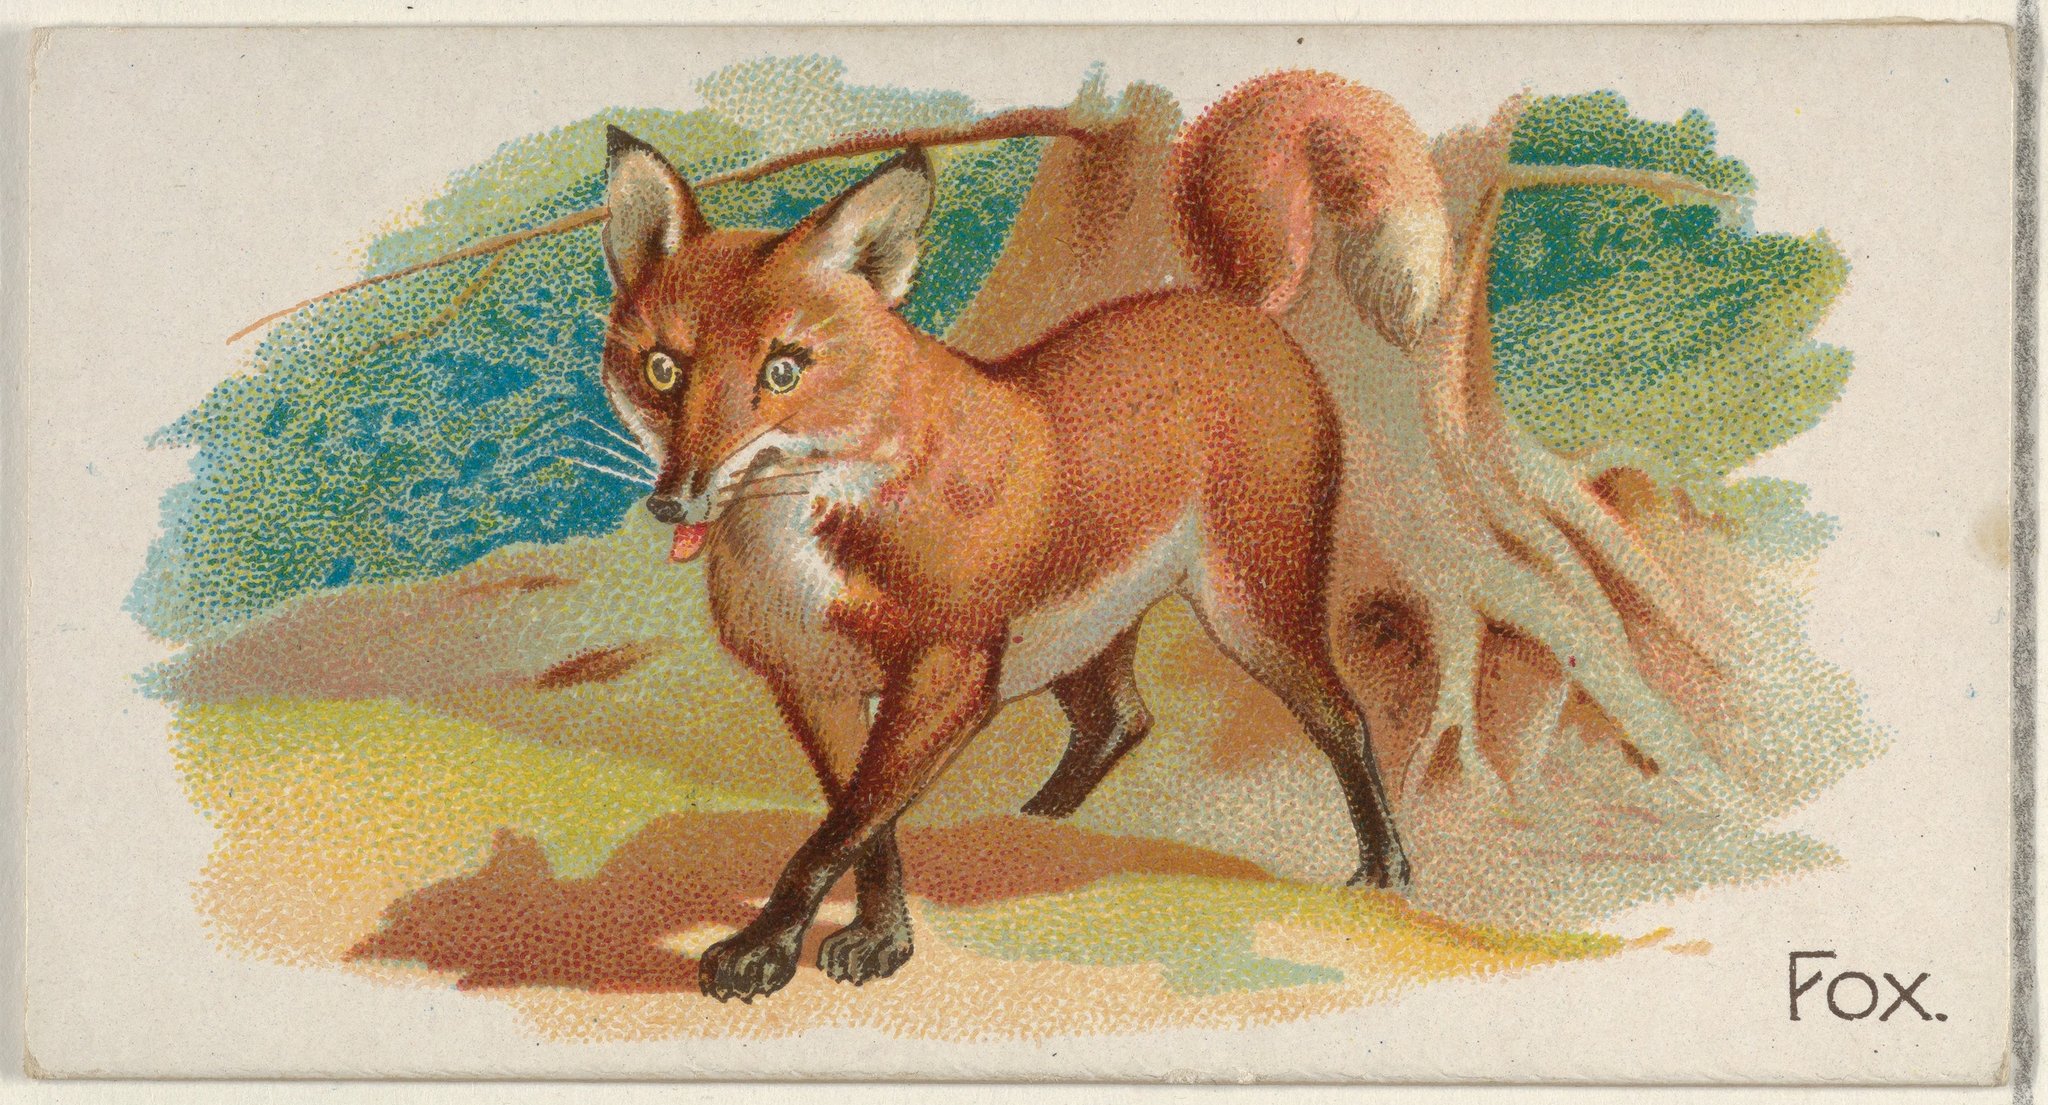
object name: print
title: Fox, from the Quadrupeds series (N21) for Allen & Ginter Cigarettes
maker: allen & ginter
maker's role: publisher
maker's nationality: american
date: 1890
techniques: color lithograph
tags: foxes